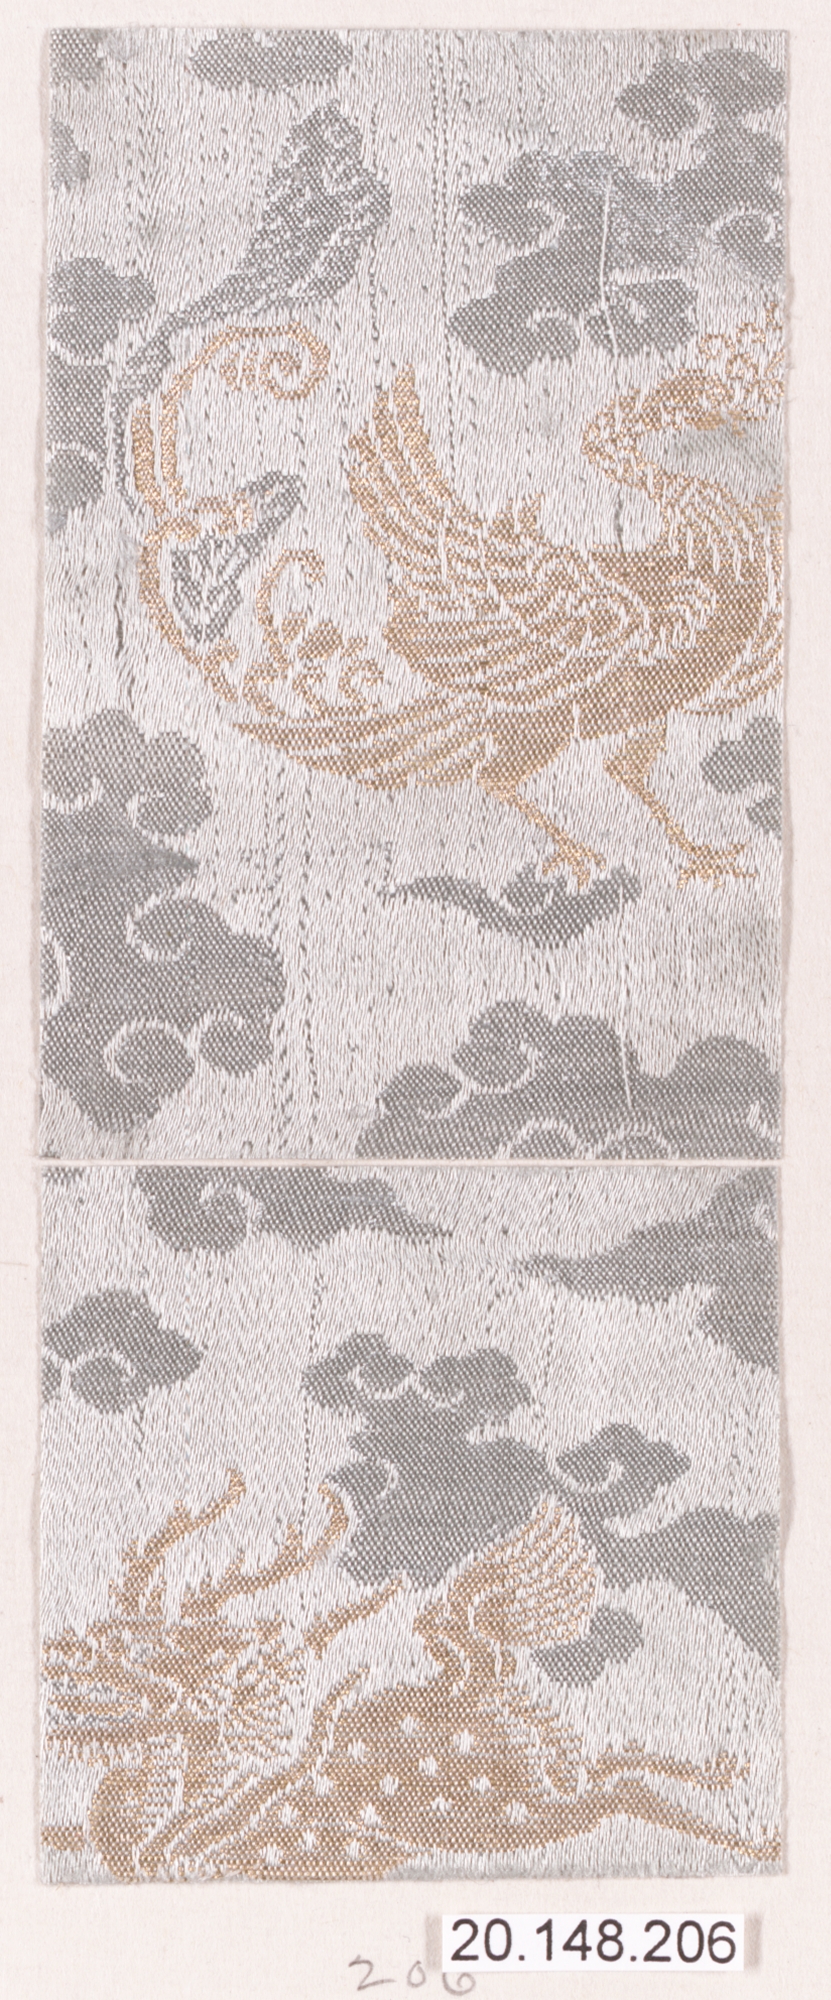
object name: piece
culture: japanese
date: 1701-1800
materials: silk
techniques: compound weave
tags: birds